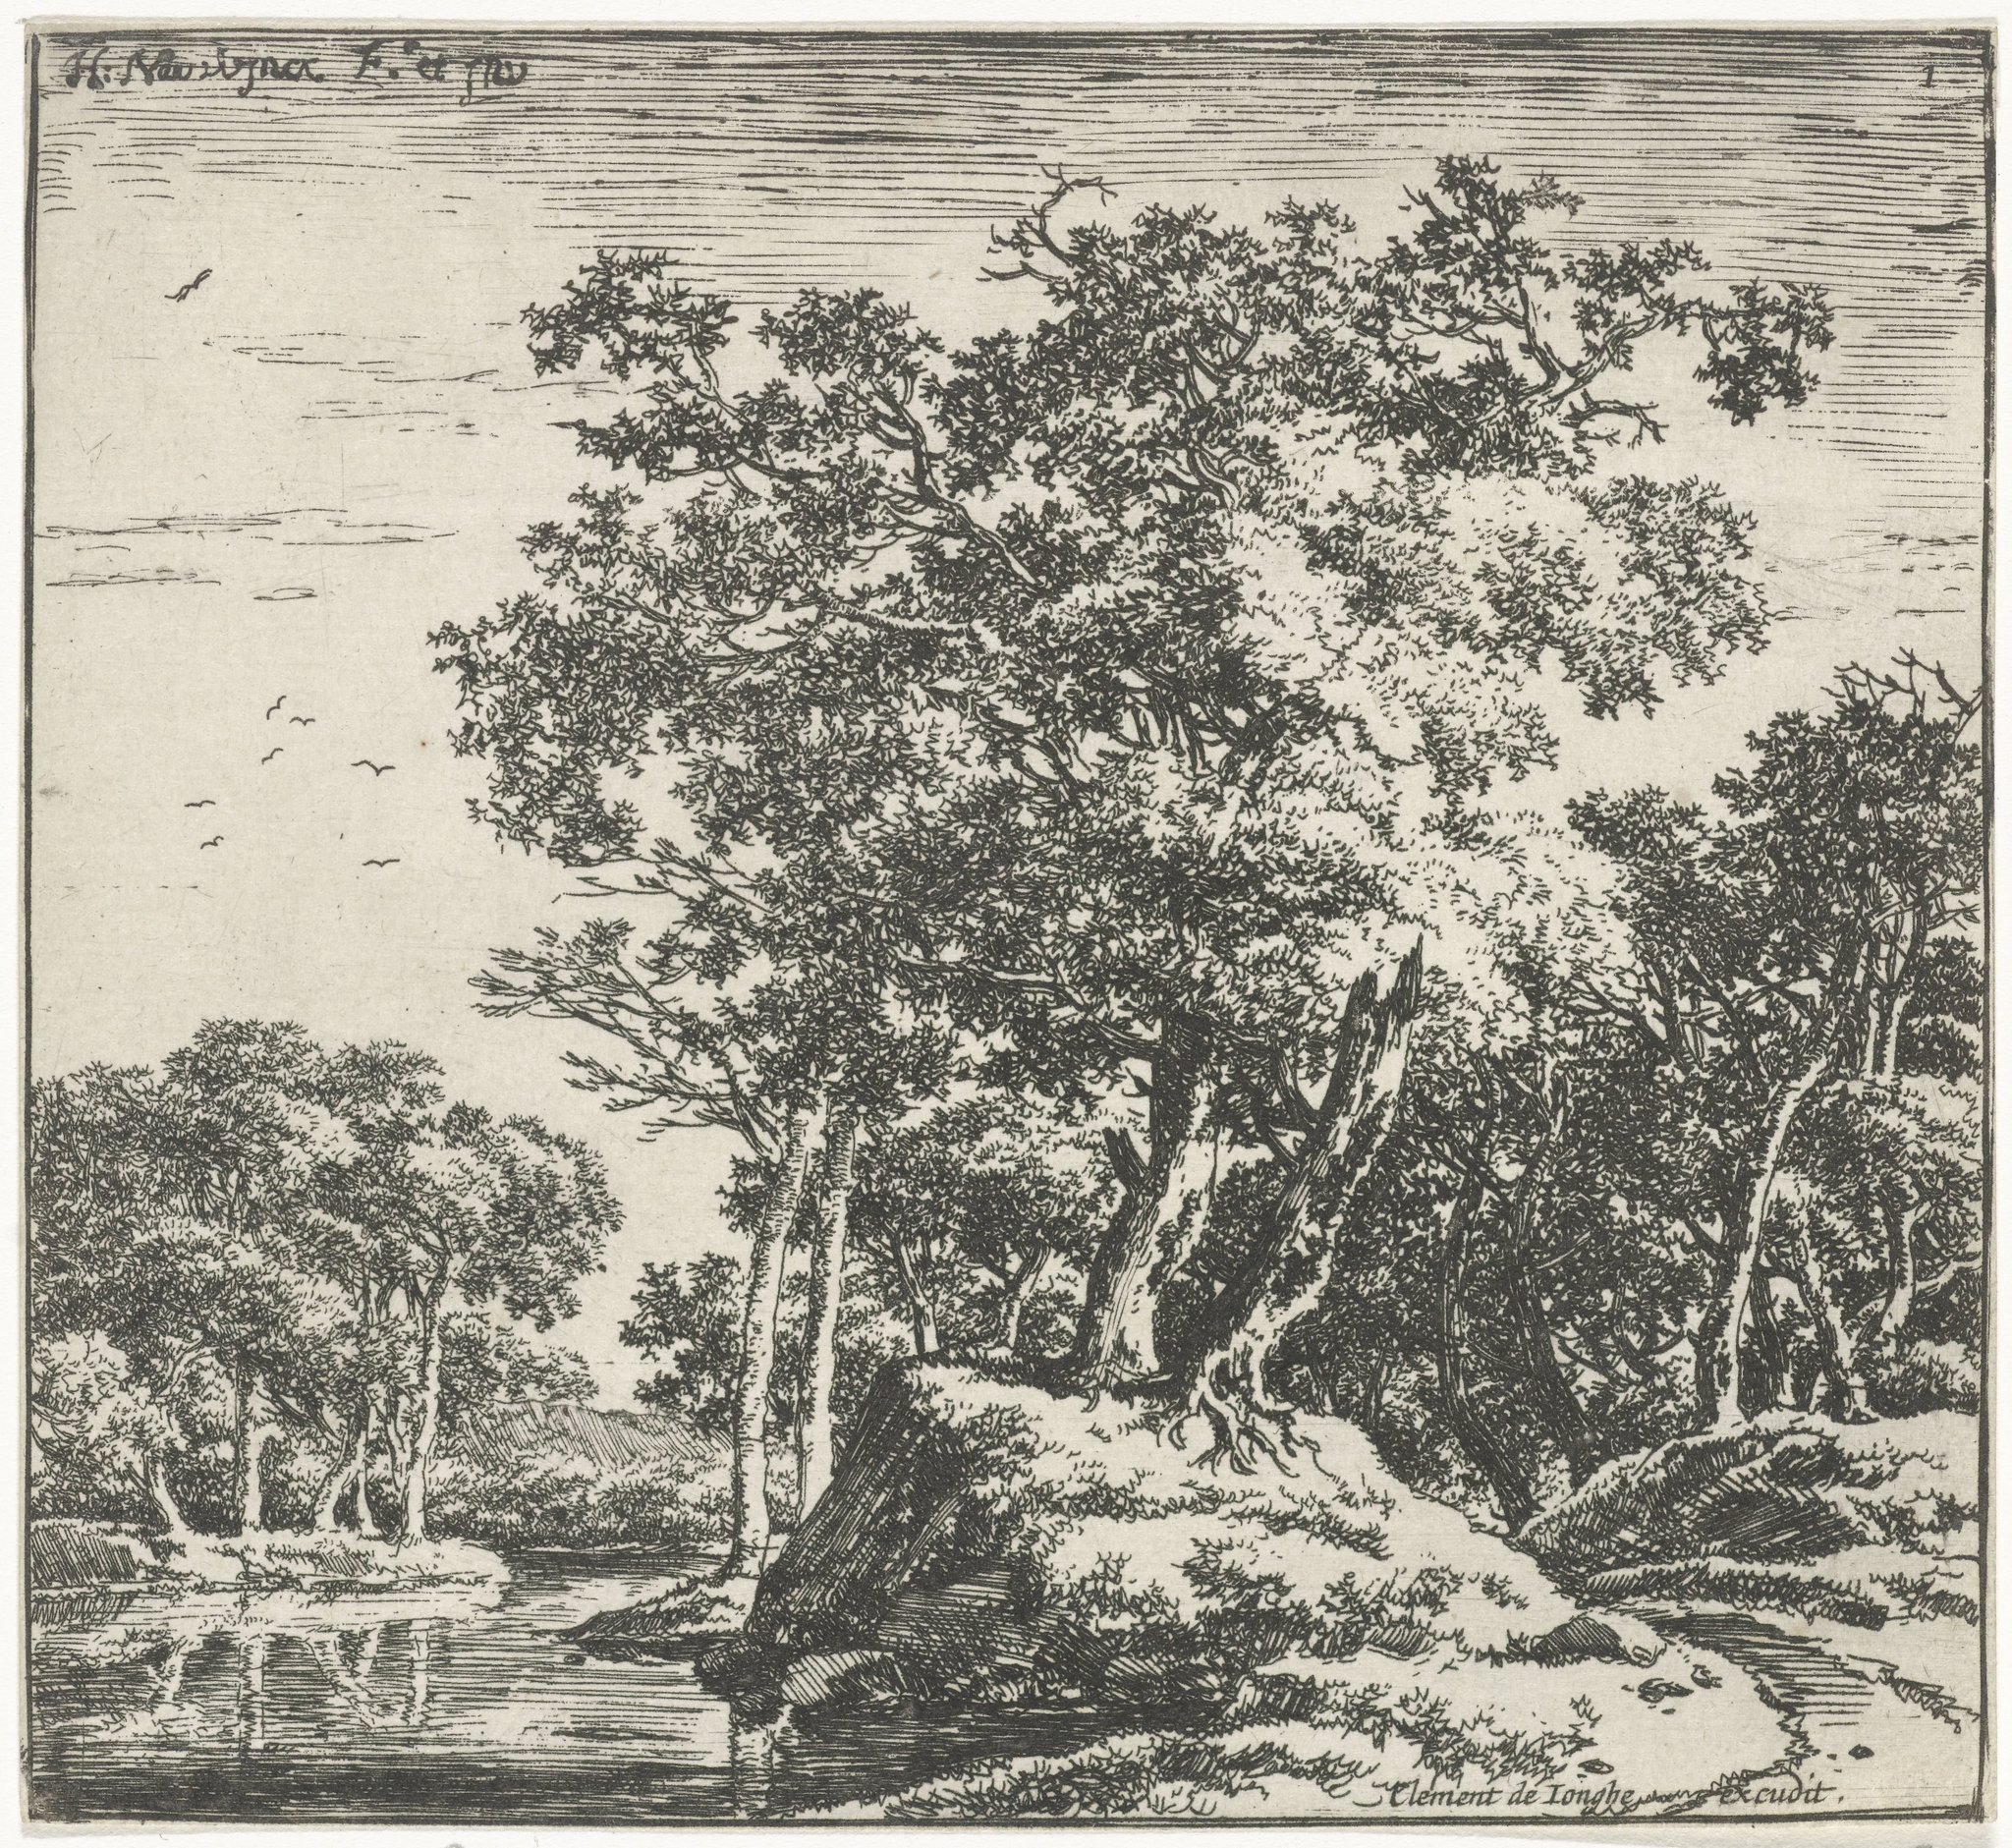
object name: print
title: Serie 1: Landschappen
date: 1633-1670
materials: paper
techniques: etching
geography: amsterdam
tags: water course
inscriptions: collector's mark: Lugt 240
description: Landschap met twee bomen op een heuvel, links water.